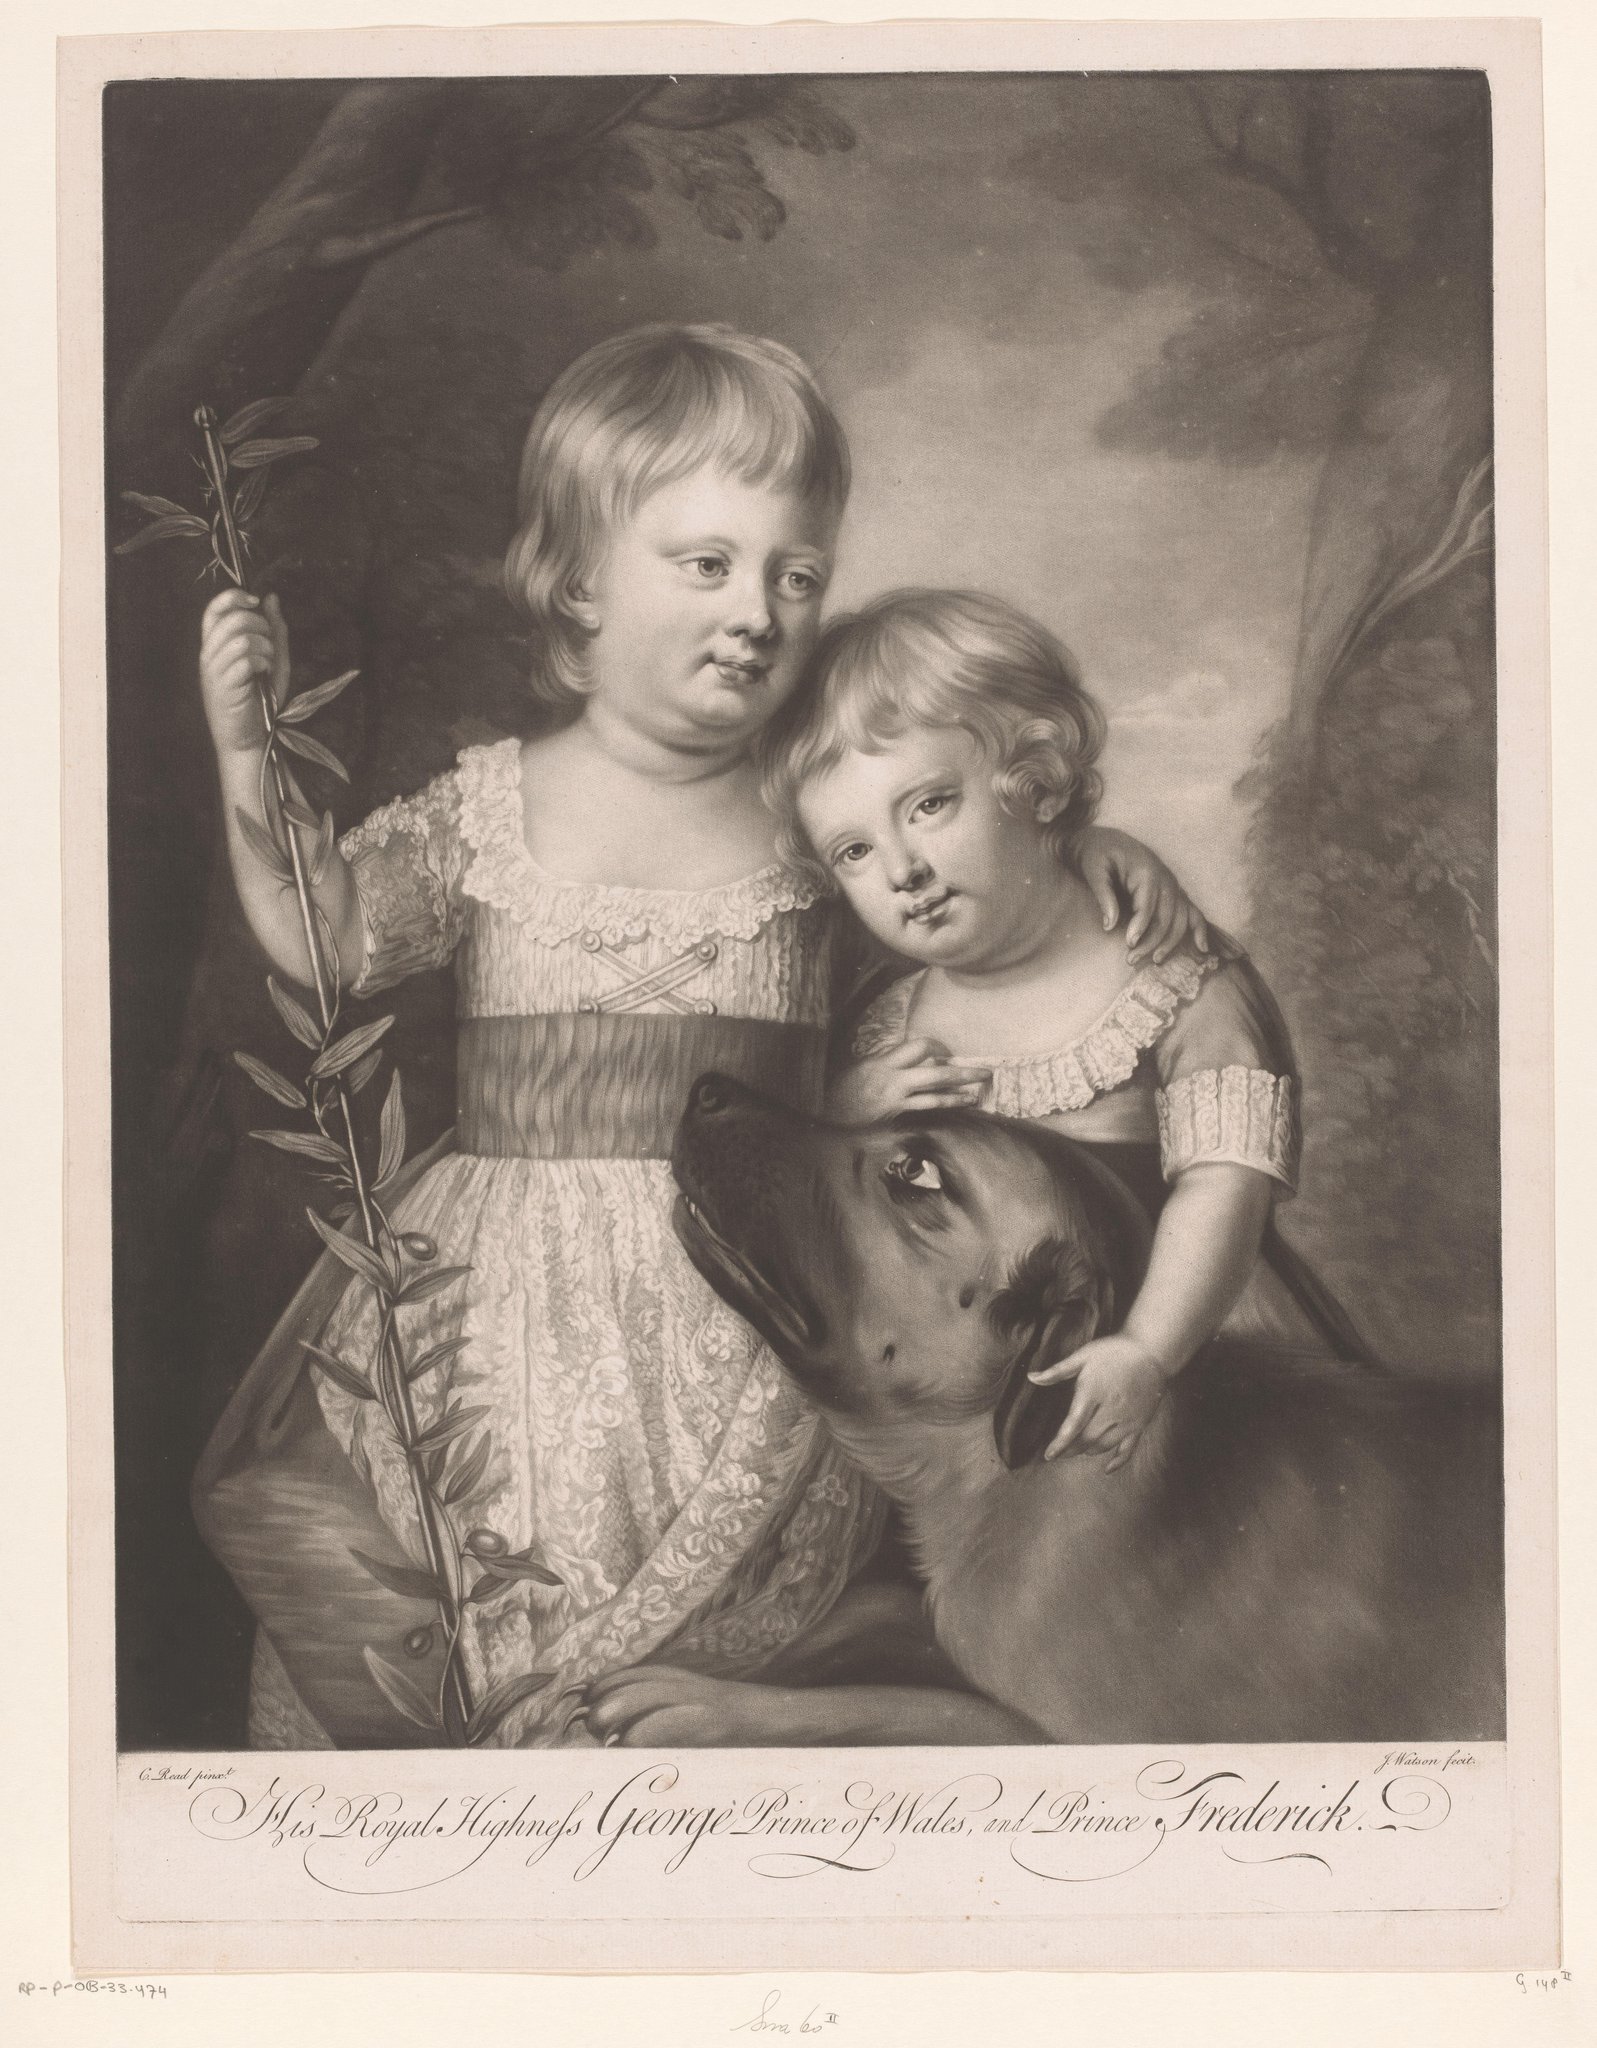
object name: print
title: Portret van George IV en Frederik Augustus als kinderen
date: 1765-1770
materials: paper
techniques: mezzotint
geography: london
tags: london, frederik (hertog van york en albany), george iv (koning van het verenigd koninkrijk), historical persons, dog, brothers (second degree family relationships)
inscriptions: collector's mark: Lugt 240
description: Links staat George. Frederik Augustus legt zijn arm om een hond.